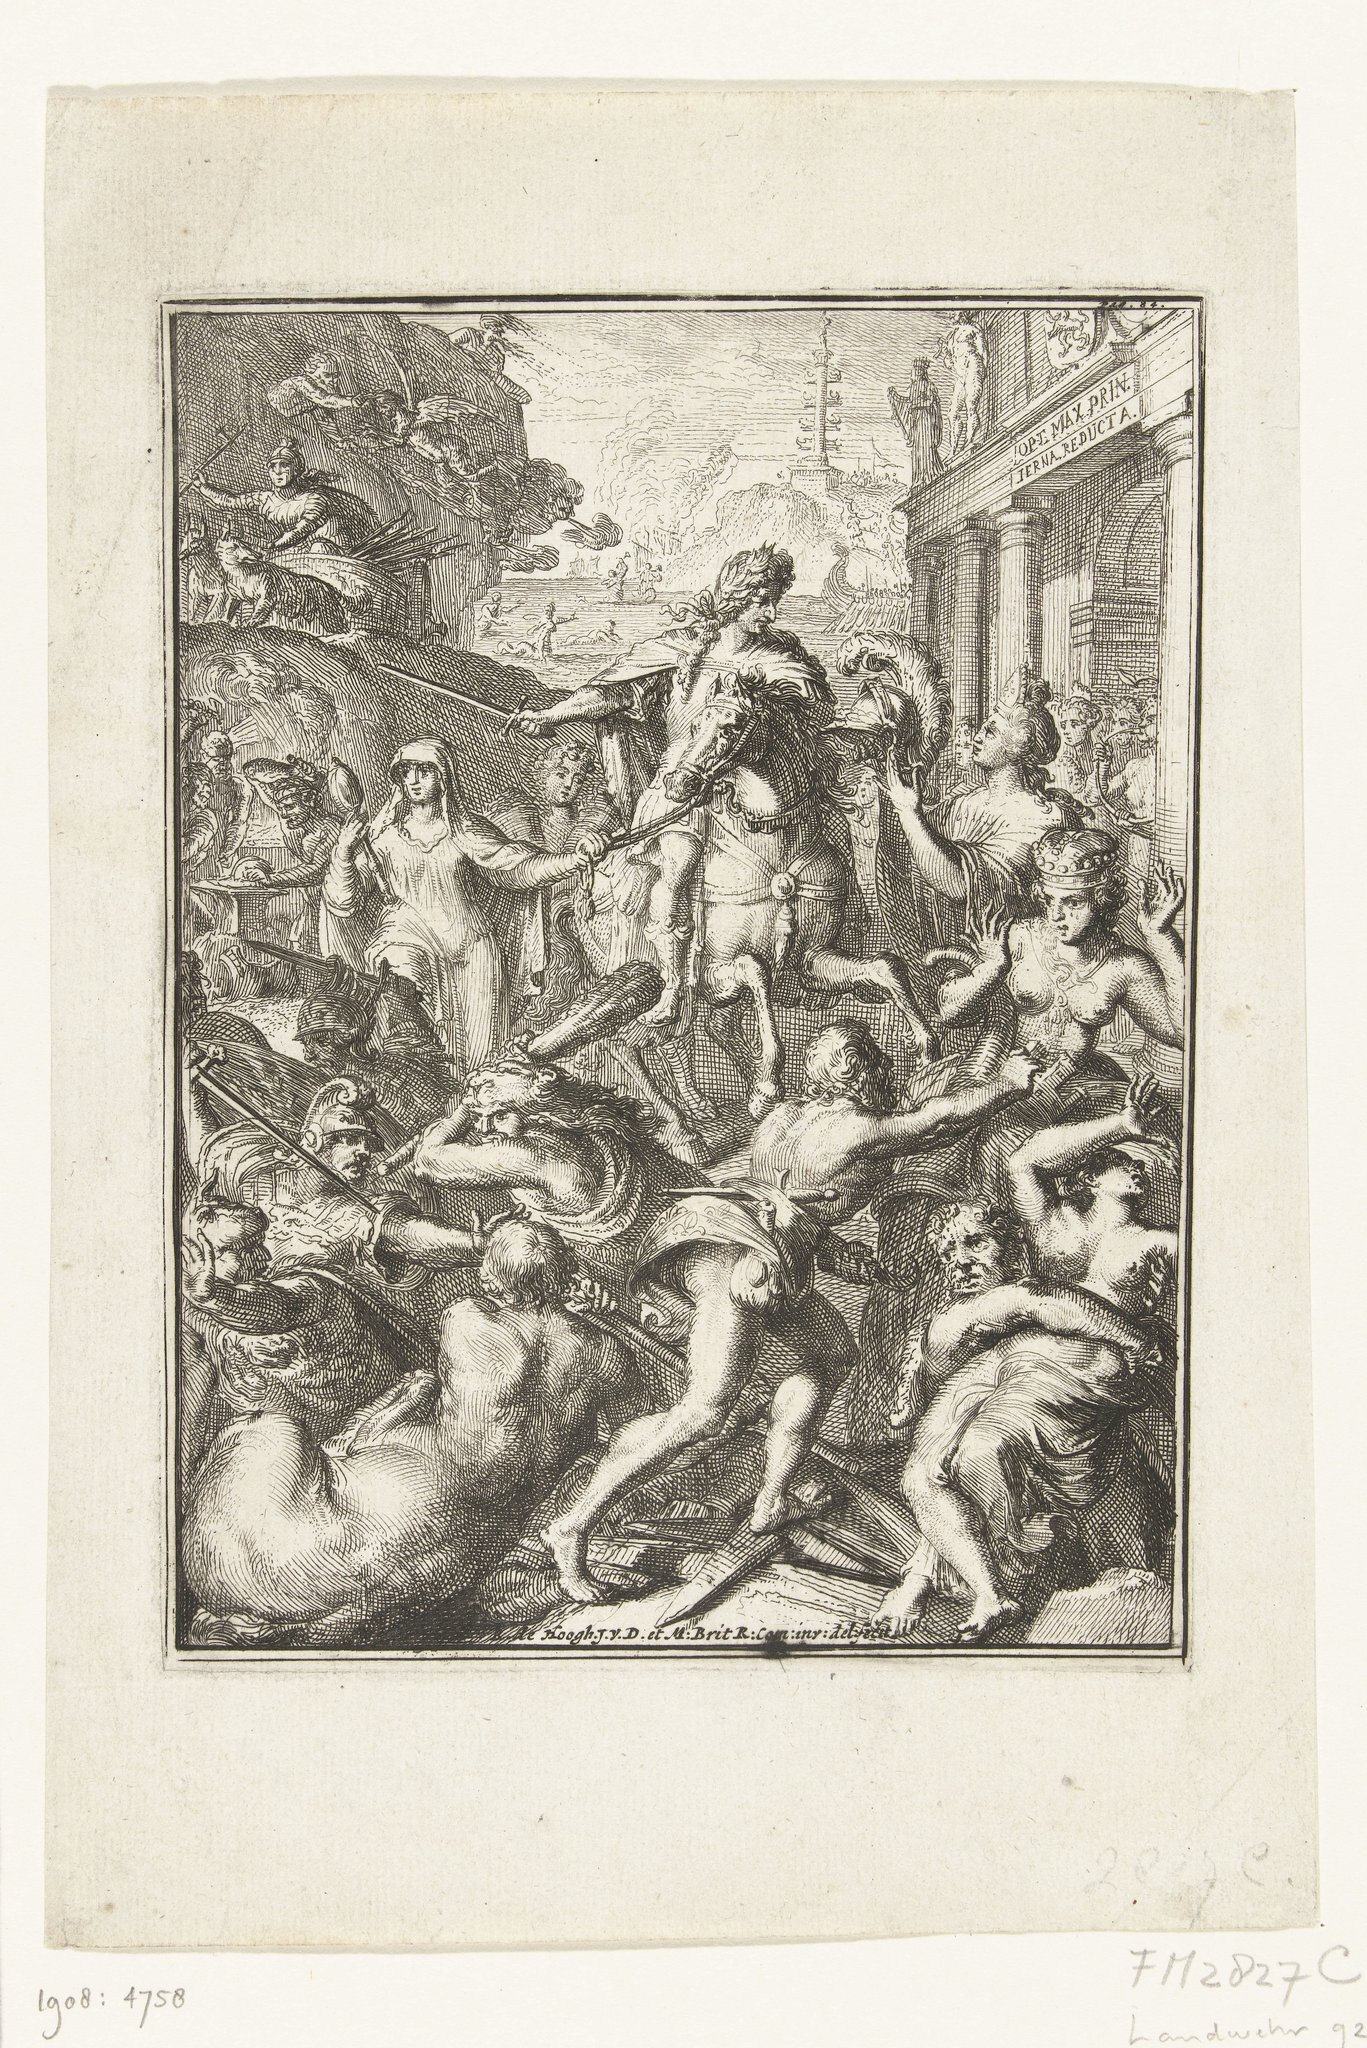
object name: print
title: Frontispice voor L. Rotgans, Wilhelm de Derde, 1700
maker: romeyn de hooghe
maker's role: draughtsman, goldsmith, painter, print maker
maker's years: 1645-1708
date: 1698-1700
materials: paper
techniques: etching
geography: northern netherlands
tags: the hague, william iii (prince of orange and king of england, scotland, and ireland)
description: Frontispice voor: Lucas Jacobsz. Rotgans, Wilhelm de Derde, door Gods genade Koningk van Engeland, Schotland, Vrankryk en Ierland, F. Halma, Amsterdam 1700.